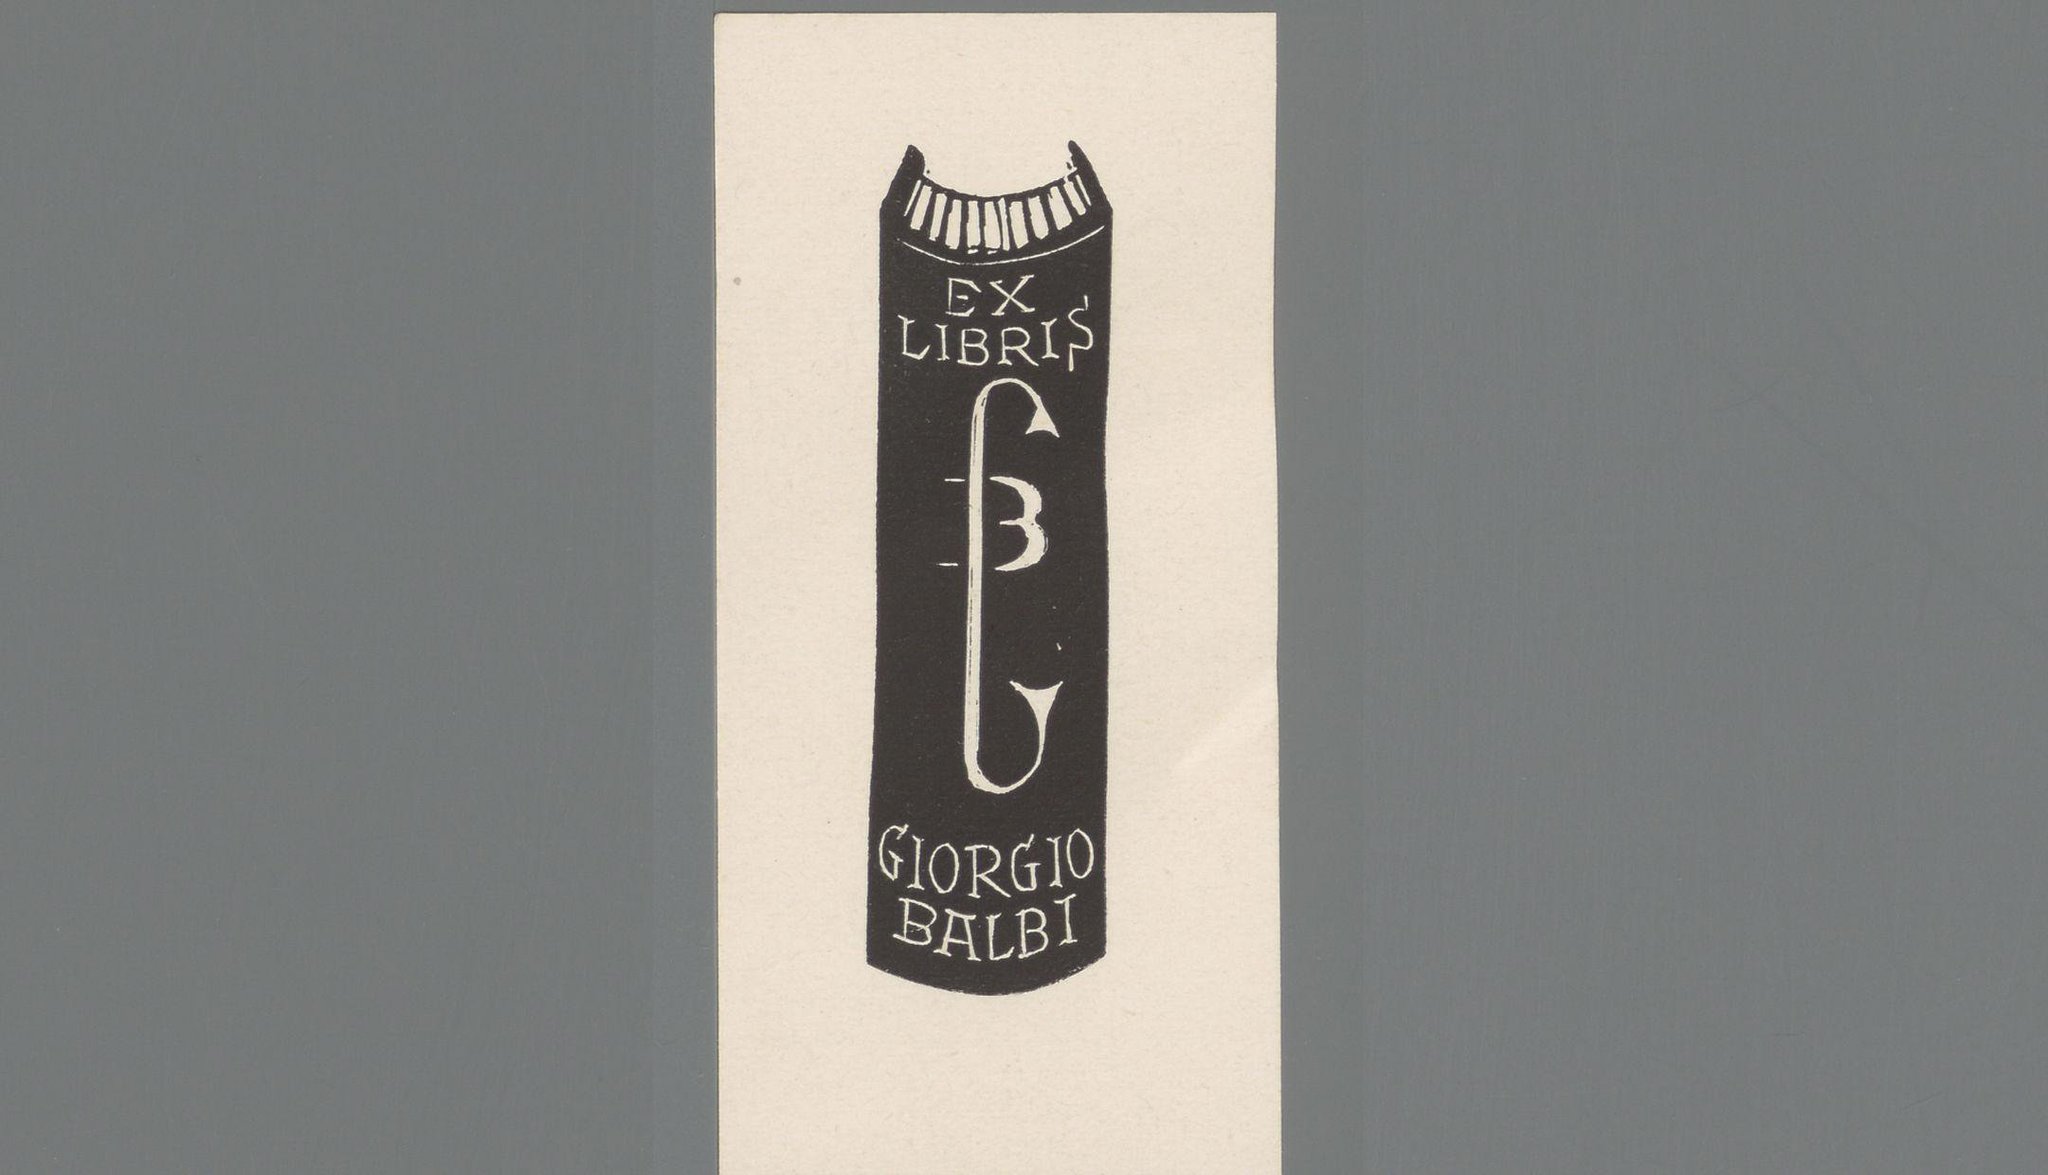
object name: bookplate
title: Ex libris van Giorgio Balbi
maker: theo broekstra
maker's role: print maker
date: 1948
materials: paper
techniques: woodcut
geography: netherlands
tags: book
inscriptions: inscription: ‘Broekstra / 223’